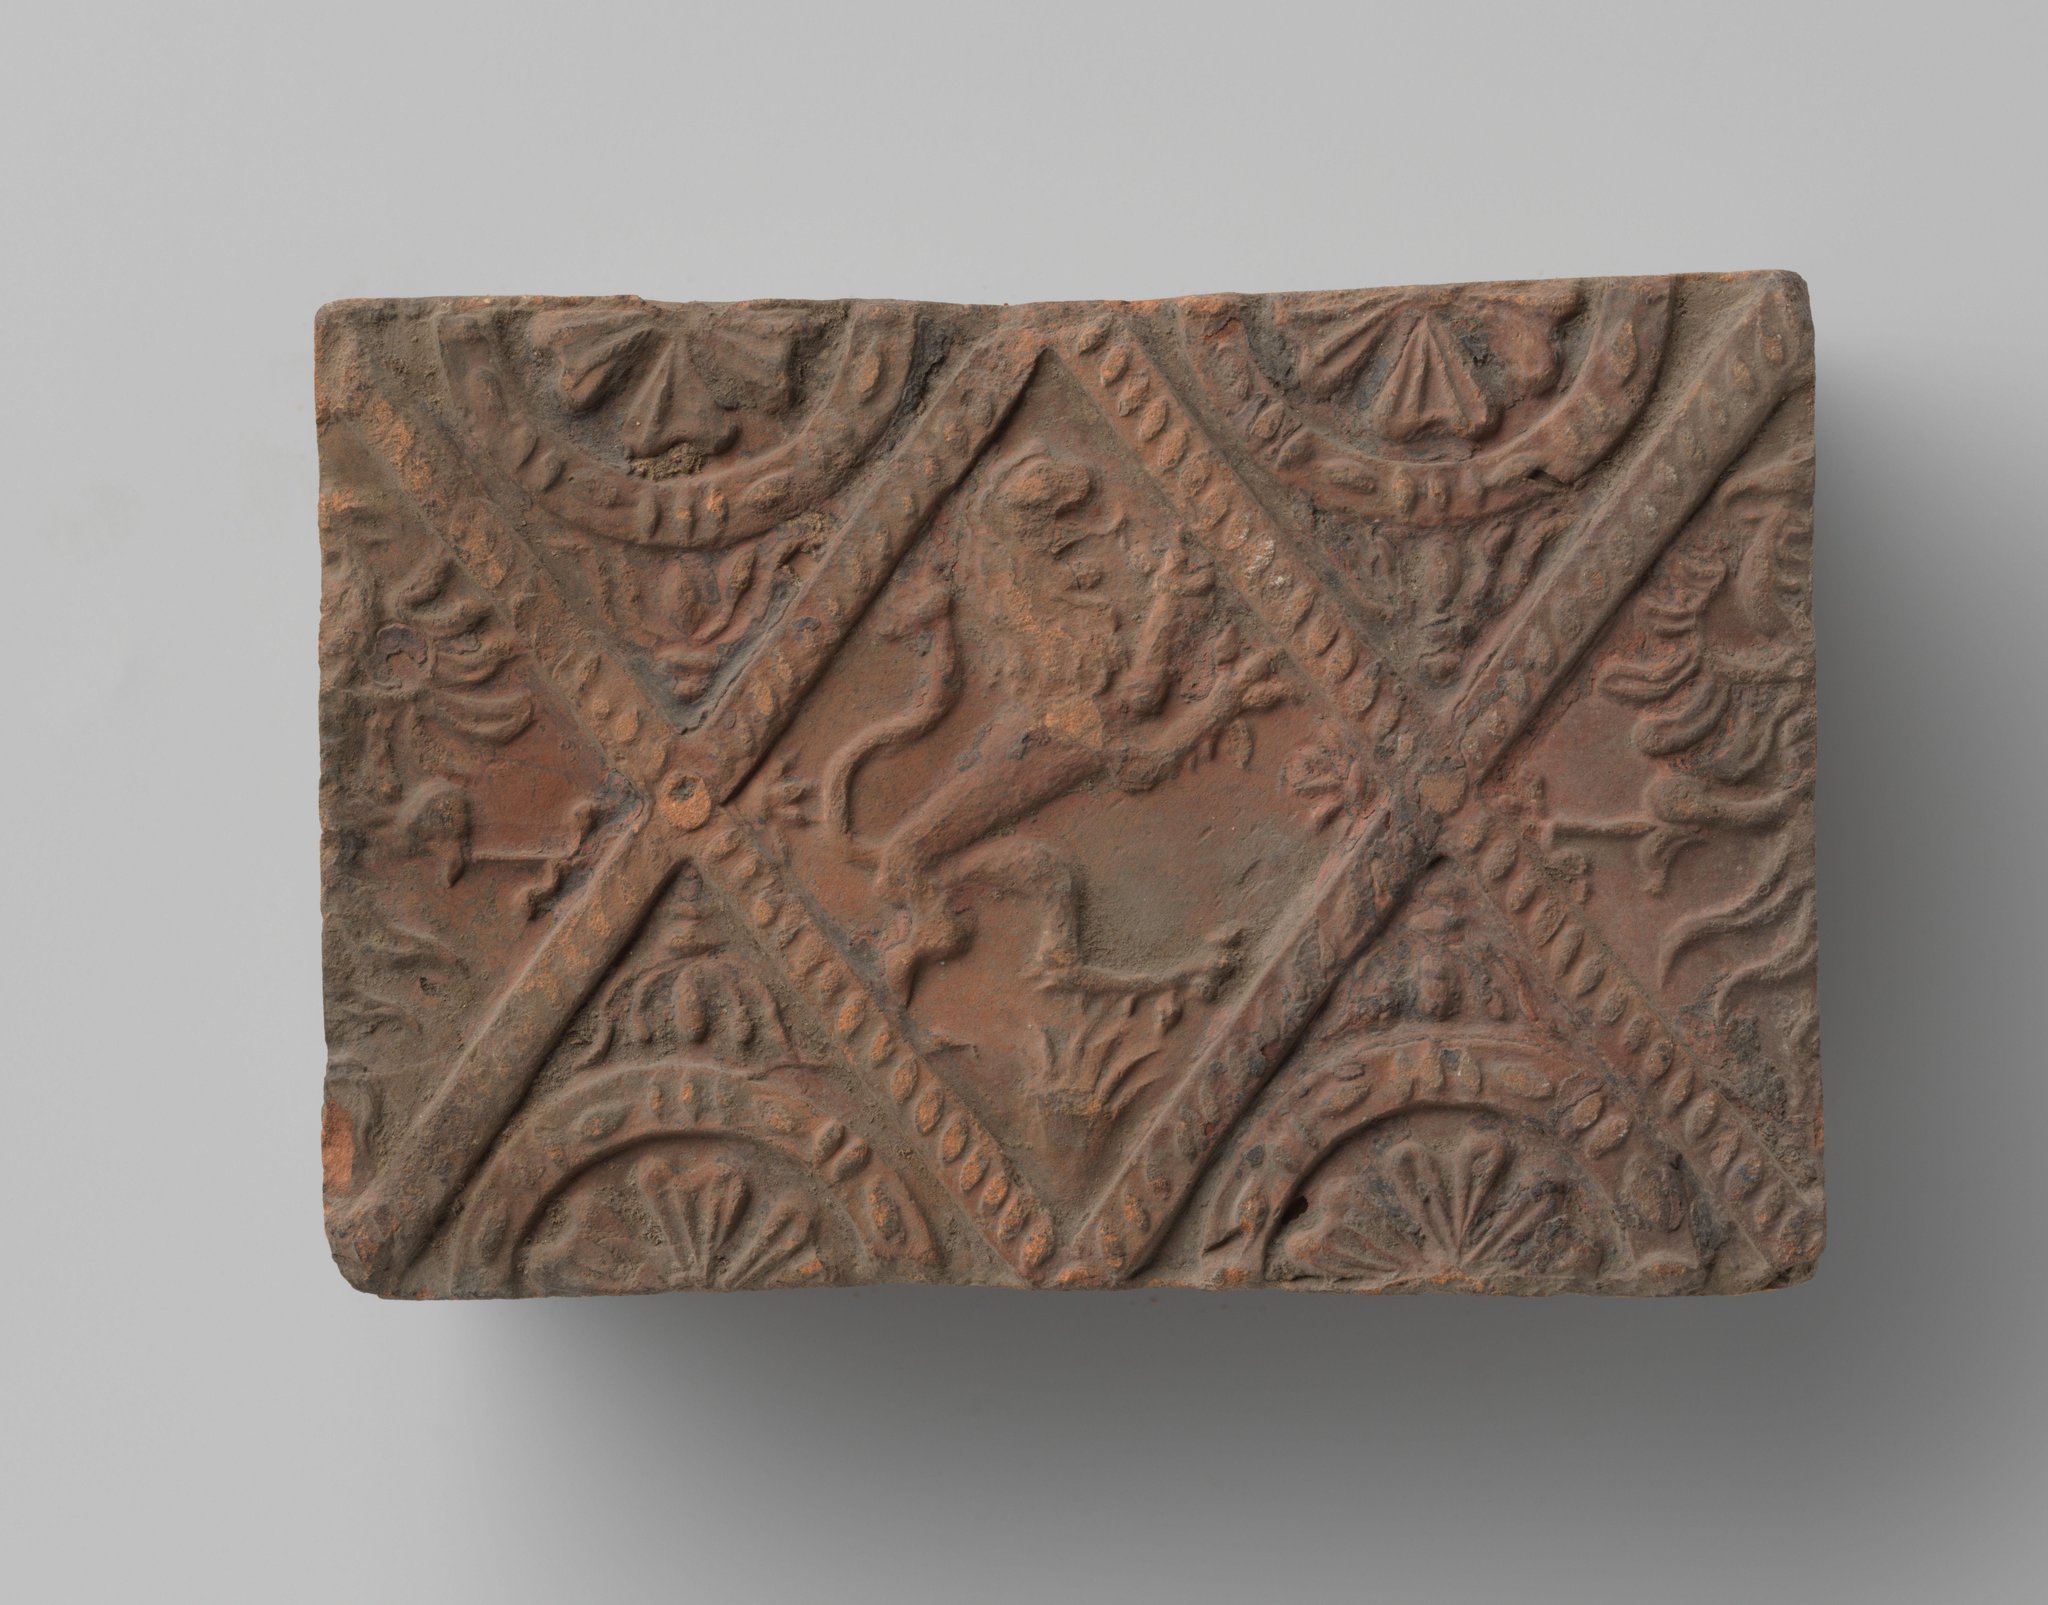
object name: hearthstone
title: Haardsteen met voorstelling van klimmende leeuw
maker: Anonymous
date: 1575-1625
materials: earthenware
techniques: printing, firing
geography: southern netherlands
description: Haardsteen met voorstelling van klimmende leeuw naar links (heraldisch) , geplaatst in geprofileerde ruit. In de halve ruiten aan de zijkanten een dubbelkoppige adelaar. De halve ruiten aan de boven- en onderkant zijn opgevuld met halve medaillons met stermotief.